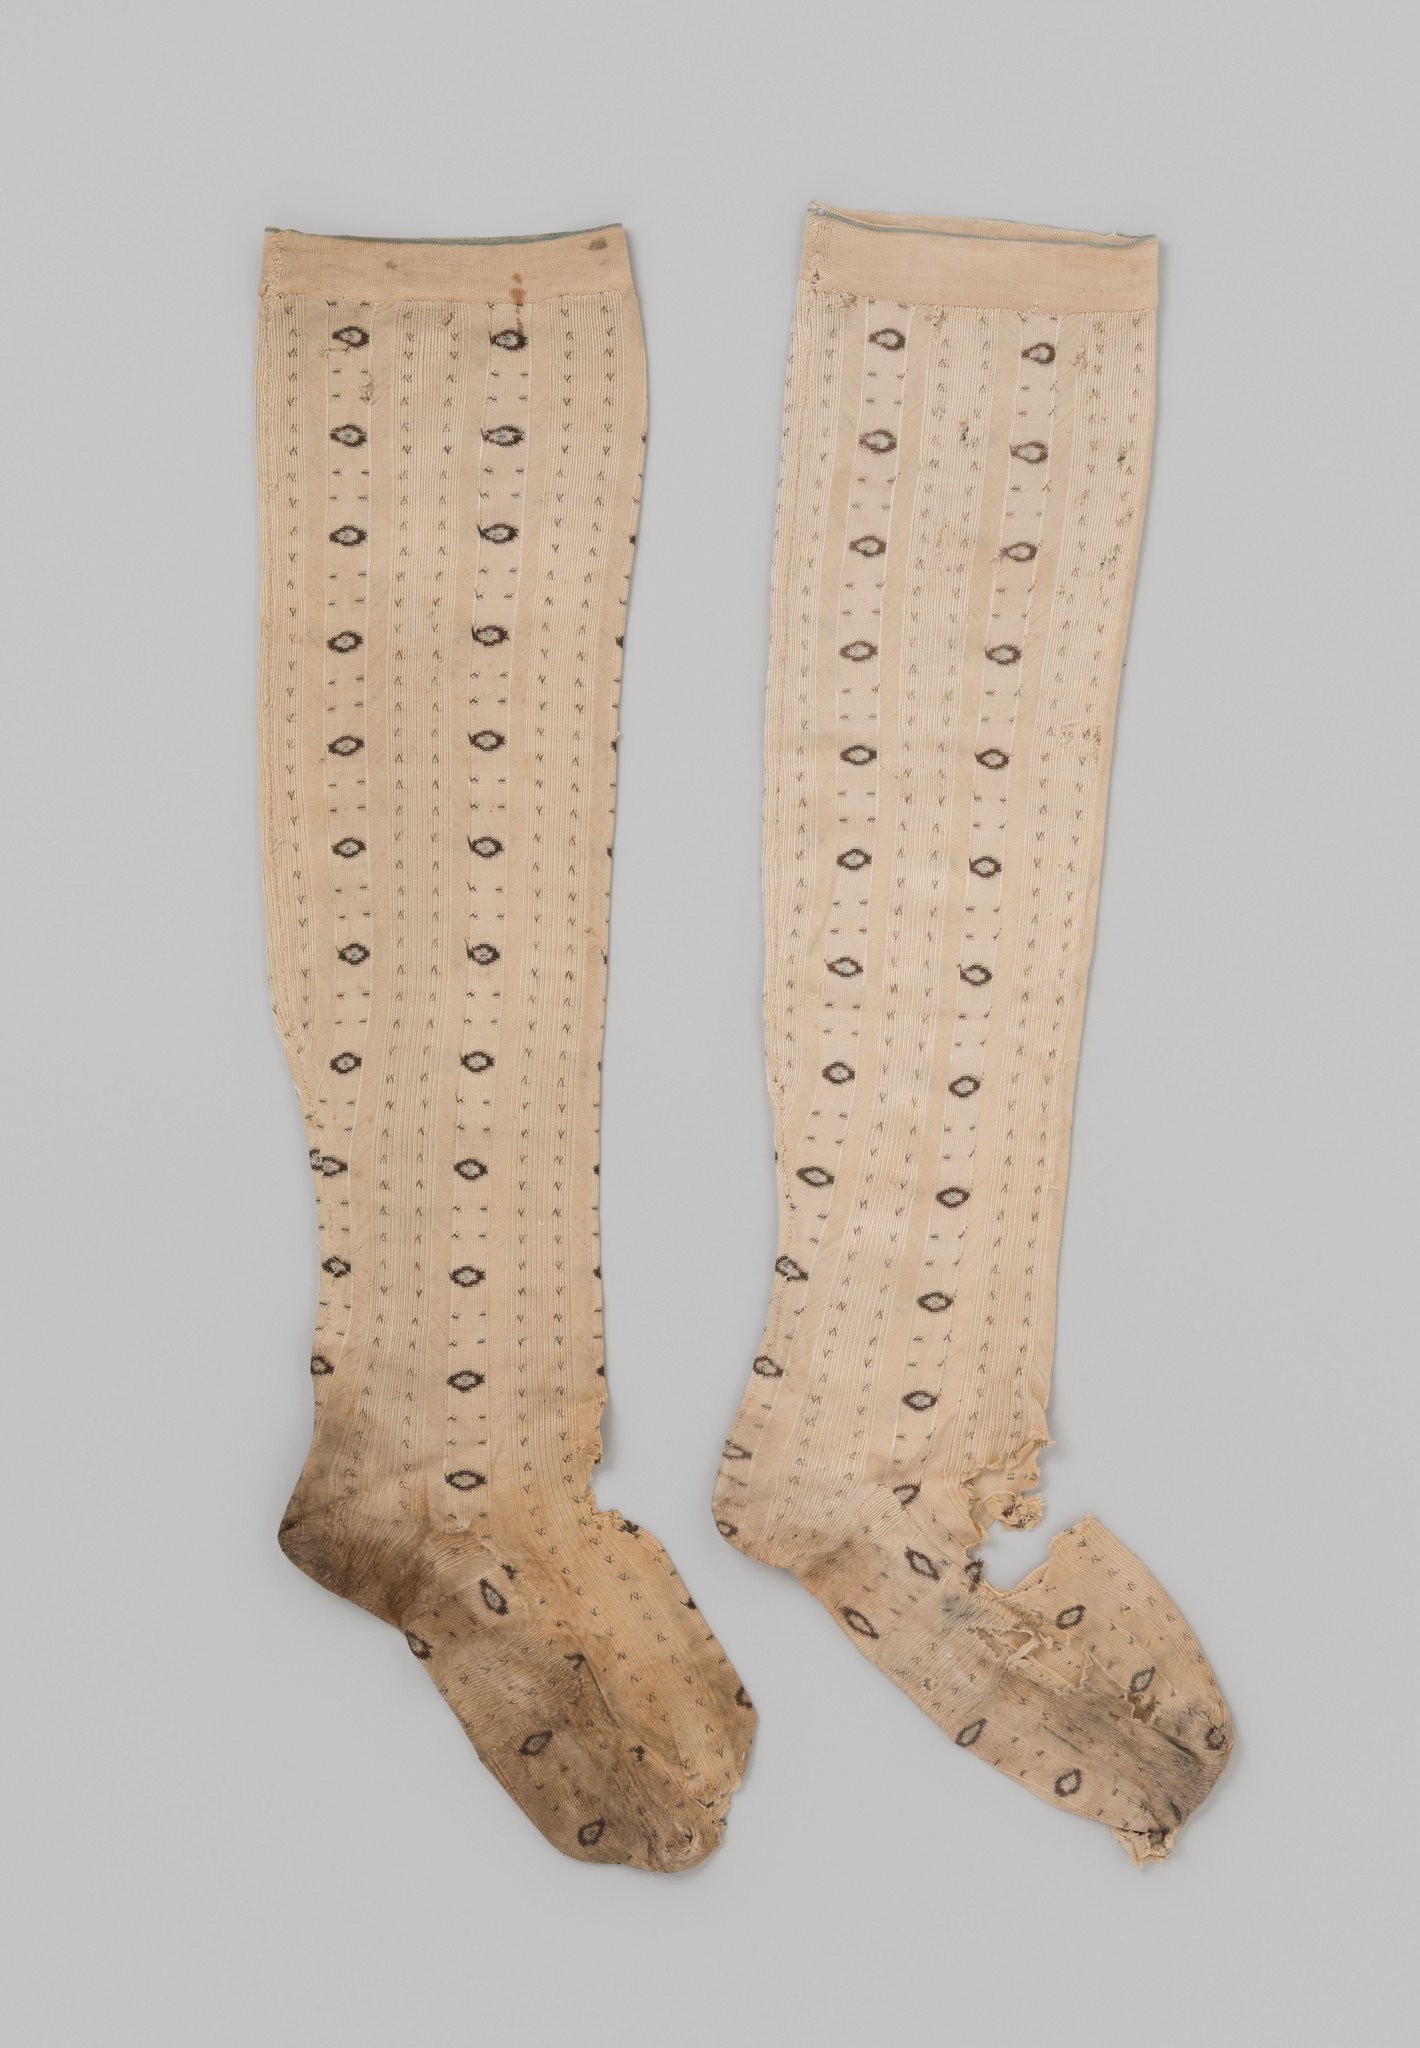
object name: stocking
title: Kous van lichtgele zijde met meegebreide verticale strepen, waarin om en om een ovaalvormig motief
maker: Anonymous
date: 1780-1800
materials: silk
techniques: knitting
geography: netherlands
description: Paar kousen van lichtgele zijde met strepen en figuurtjes, die zijn samengesteld uit een ovaal met blauwe stip en flotterende 'N'-en. Techniek: probleem. Het zwart is aan de achterzijde per steek meegenomen, maar waar het begint en eindigt is niet duidelijk- althans niet met de flotterende draden.